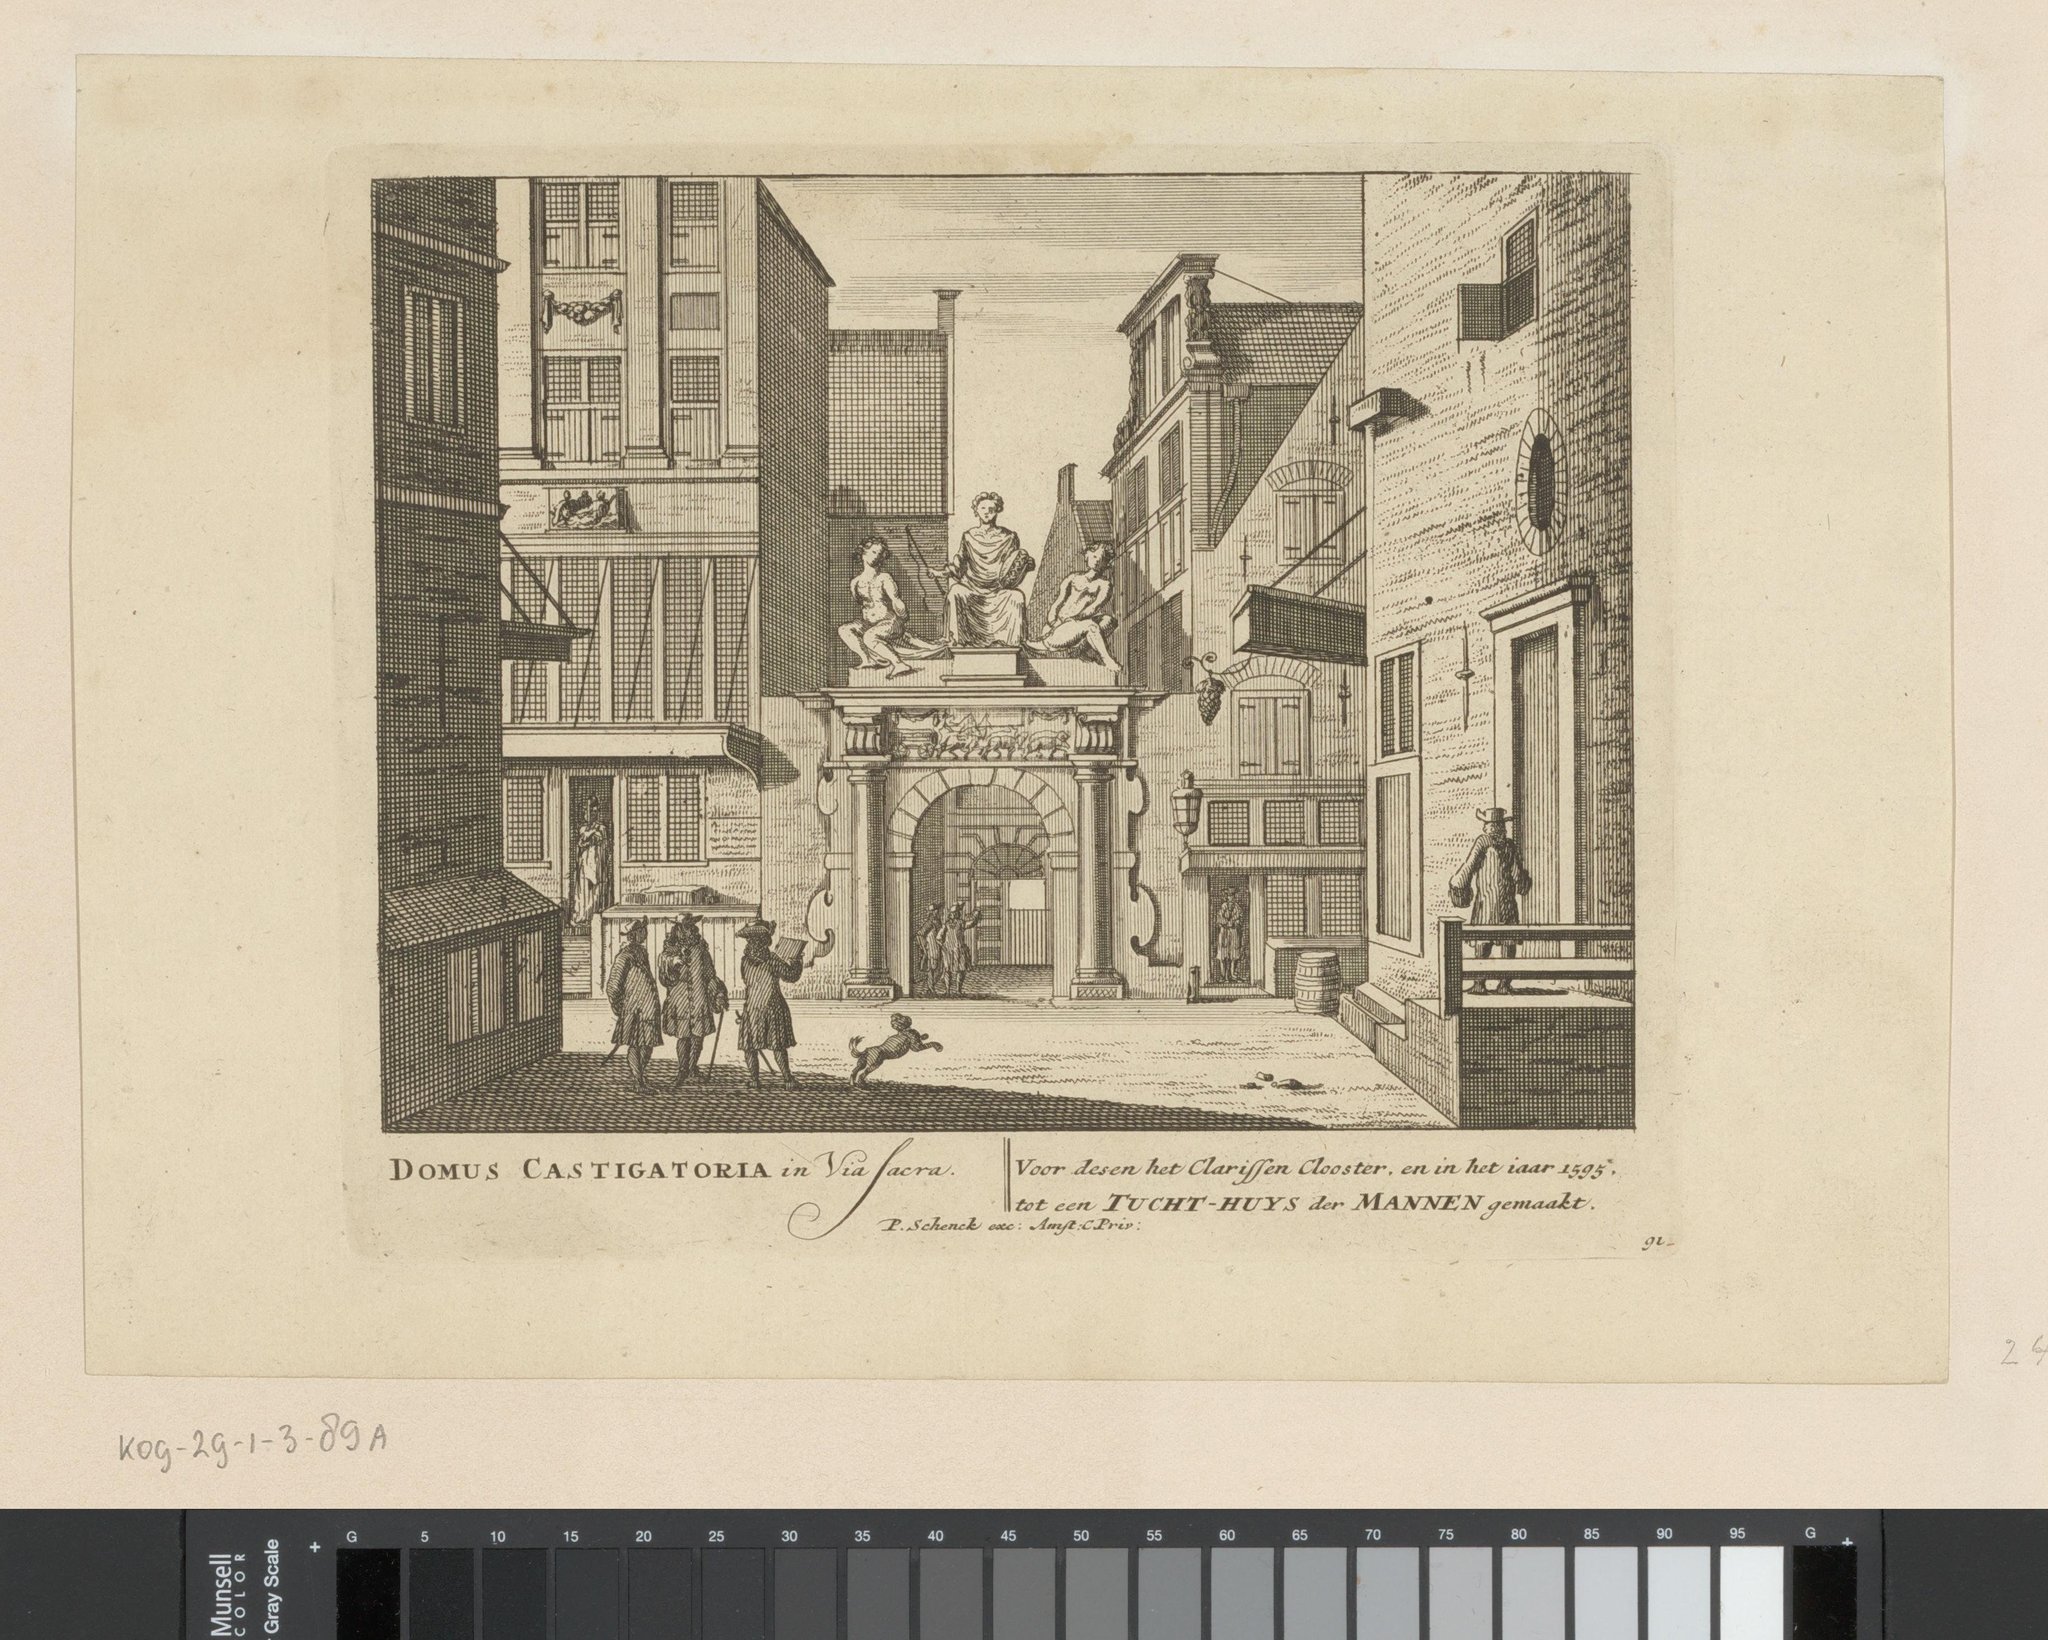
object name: print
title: 100 Afbeeldinge der voornaamste gebouwen van Amsterdam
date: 1710-1766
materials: paper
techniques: engraving, etching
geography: amsterdam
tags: prison, jail, gate, entrance, workhouse, penal camp, penitentiary, chain gang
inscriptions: stamp, collector's mark: Lugt 1641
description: Prent mogelijk uit: 100 Afbeeldinge der voornaamste gebouwen van Amsterdam. Amsterdam, Pieter Schenk (I), s.a. [1710-1711]. Of uit: 100 Afbeeldinge der voornaamste gebouwen van Amsterdam. Amsterdam: Barent Greve, s.a. [1757-1766]. In de tweede uitgave, uitgegeven door Barent Greve, is alleen de titelprent aangepast. De overige prenten zijn onveranderd gebleven.